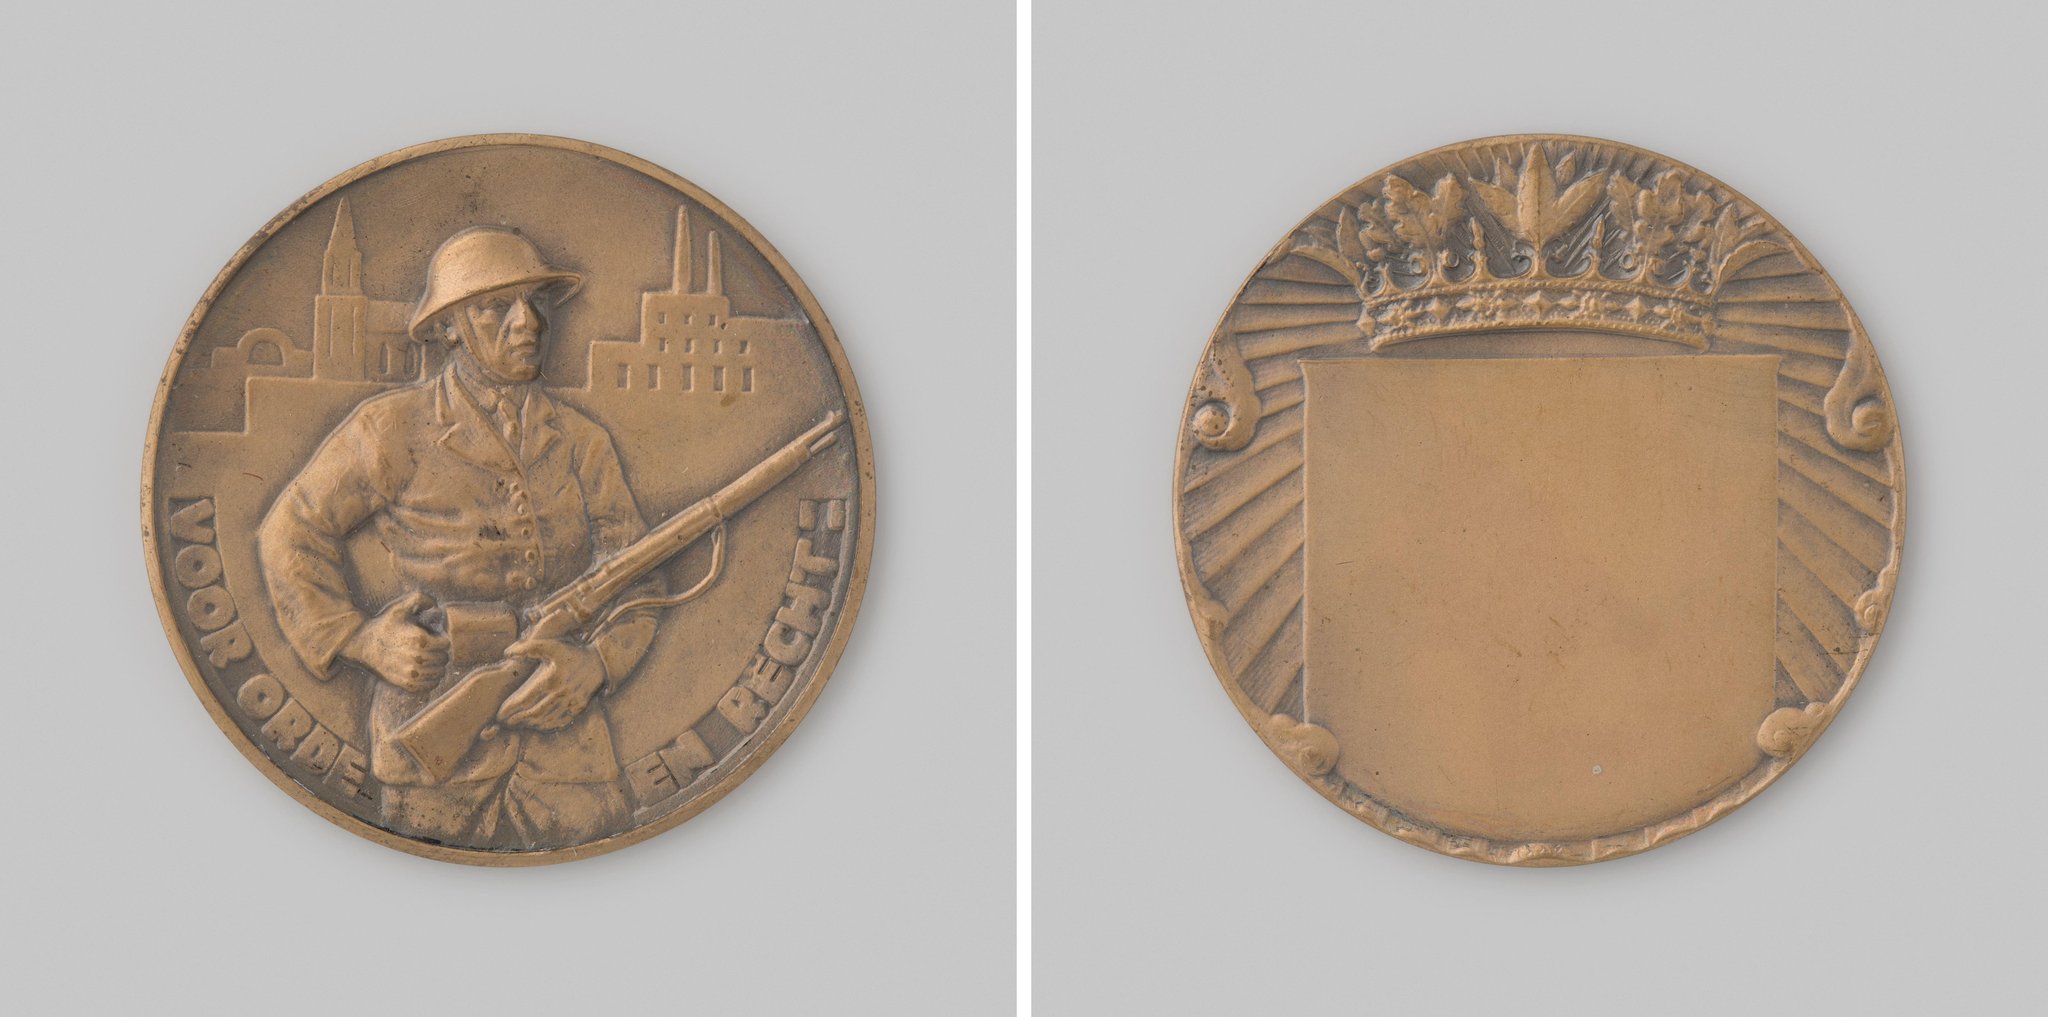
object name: insignia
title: Penning Voor Orde en Recht, gehelmde ordebewaker met geweer, Bijzondere Vrijwillige Landstorm en Burgerwacht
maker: Anonymous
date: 1938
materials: metal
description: Metalen penning. Voorzijde: gehelmde ordebewaker met geweer en op de achtergrond de contouren van een stad. Omschrift: VOOR ORDE EN RECHT. Keerzijde: kroon boven leeg wapenschild, met randversiering.